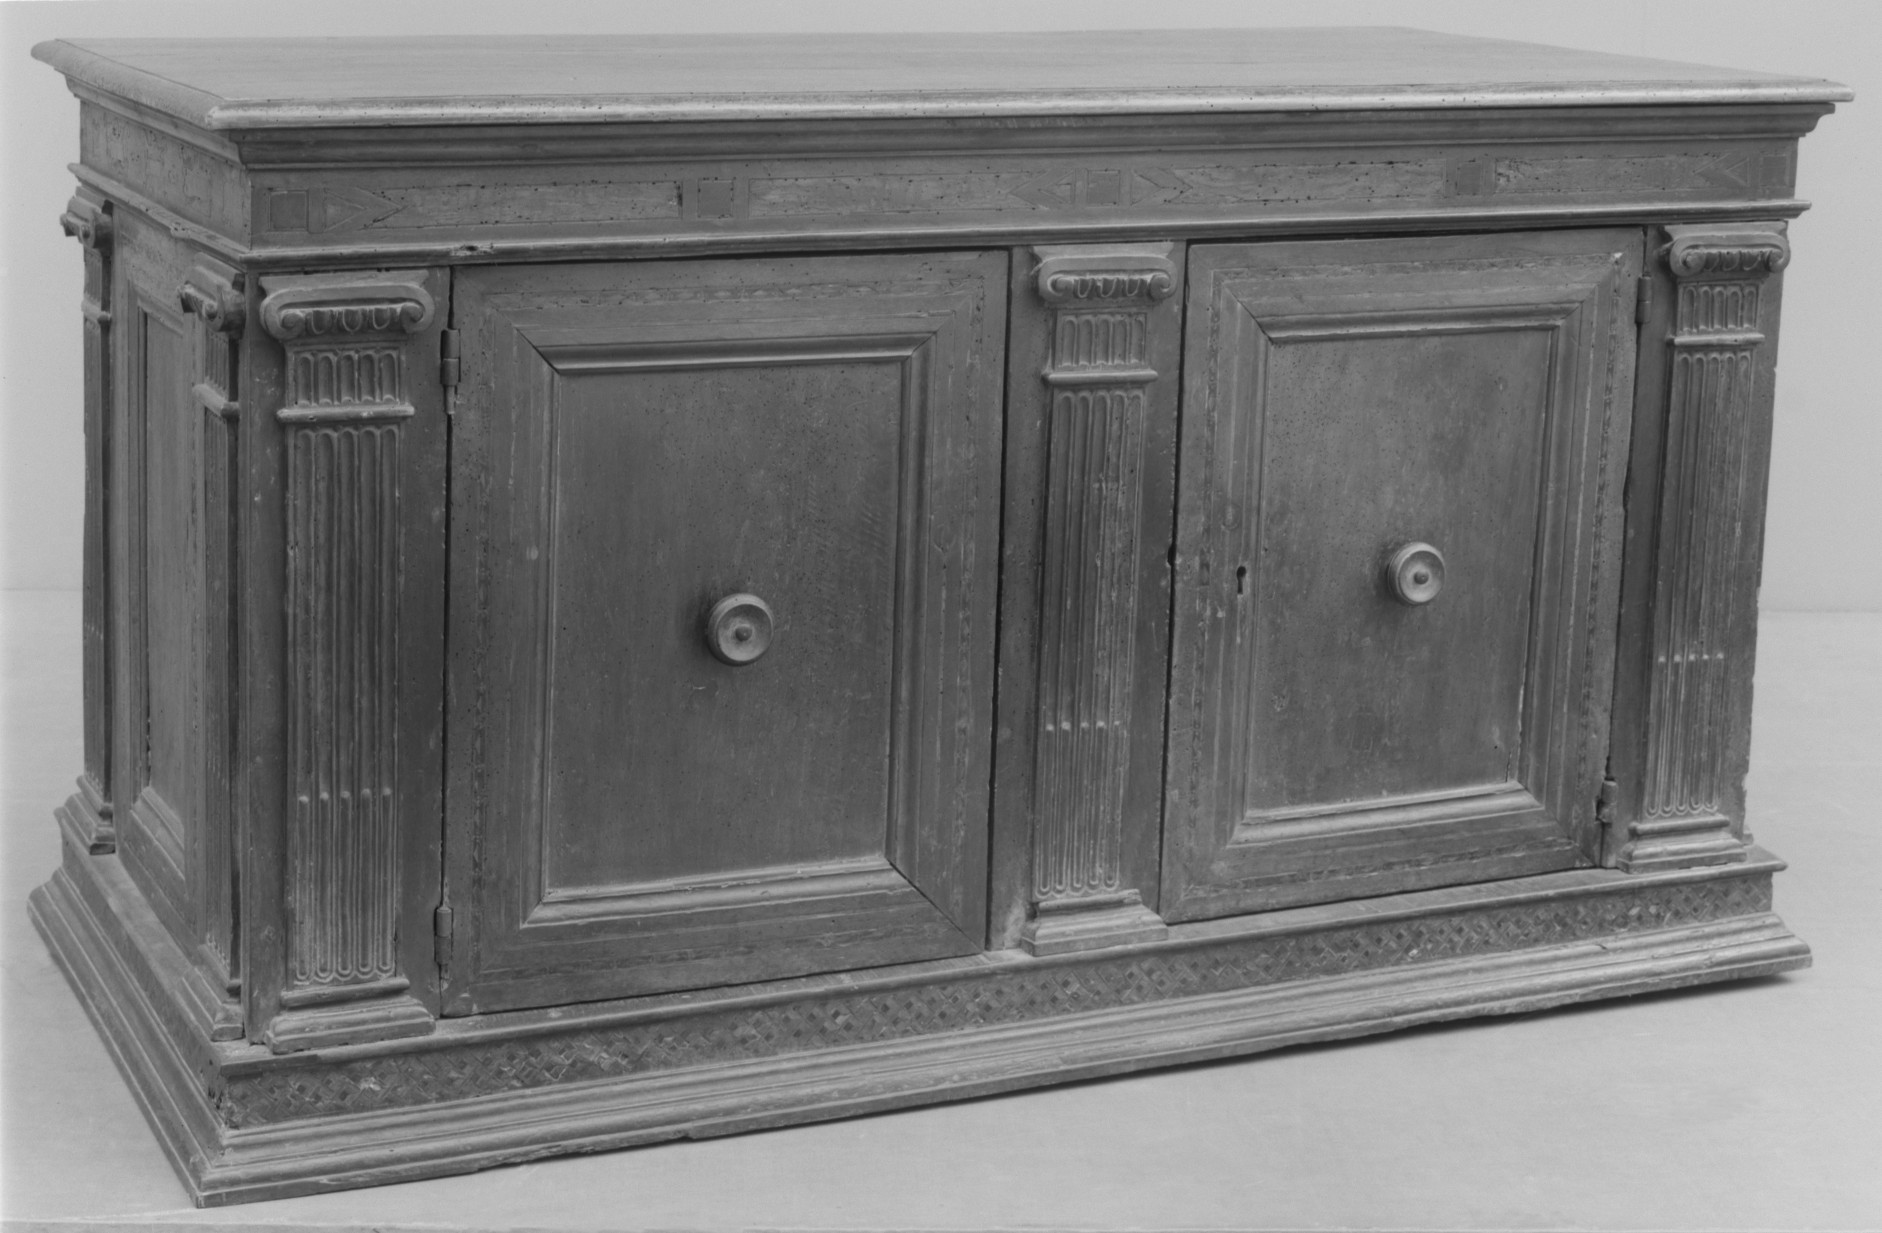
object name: cupboard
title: Sacristy cupboard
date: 1490-1500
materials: wood